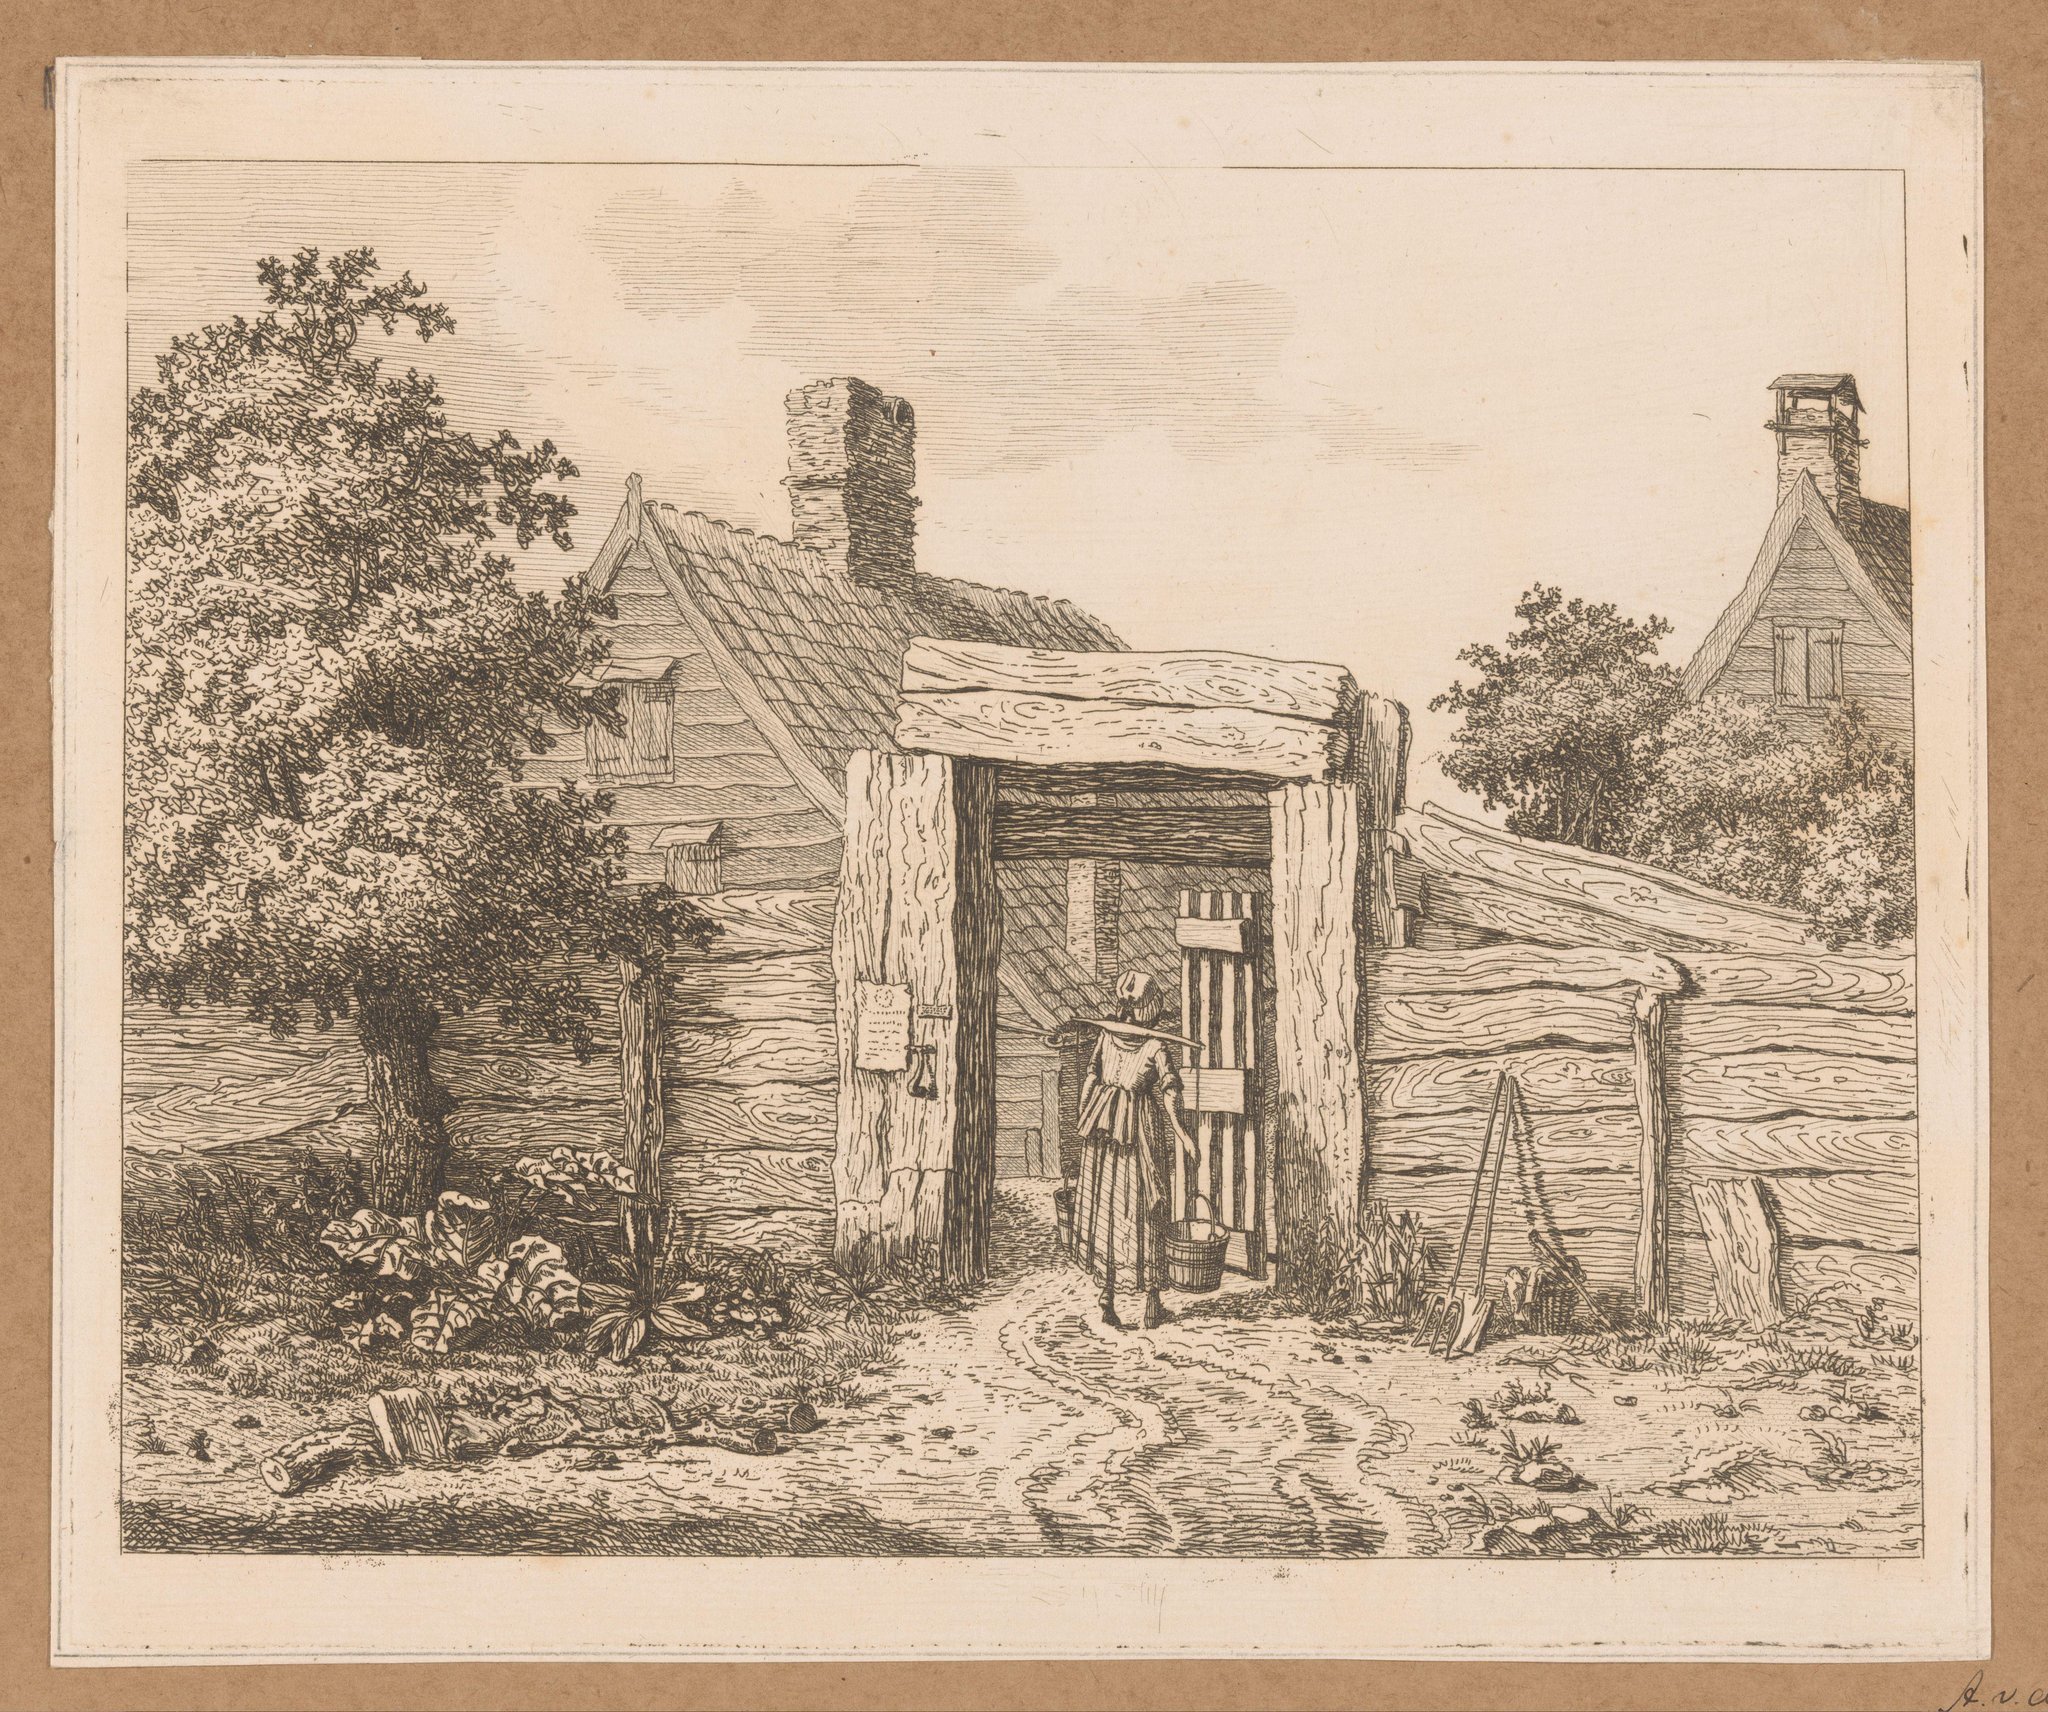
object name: print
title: Melkmeisje bij de poort van een boerderij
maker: anthonie van den bos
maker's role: draughtsman, print maker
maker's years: 1763-1838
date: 1773-1838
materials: paper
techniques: drypoint, etching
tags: milking (+ transport of products ~ crafts, industries, agriculture), farm or solitary house in landscape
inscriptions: collector's mark: Lugt 2233